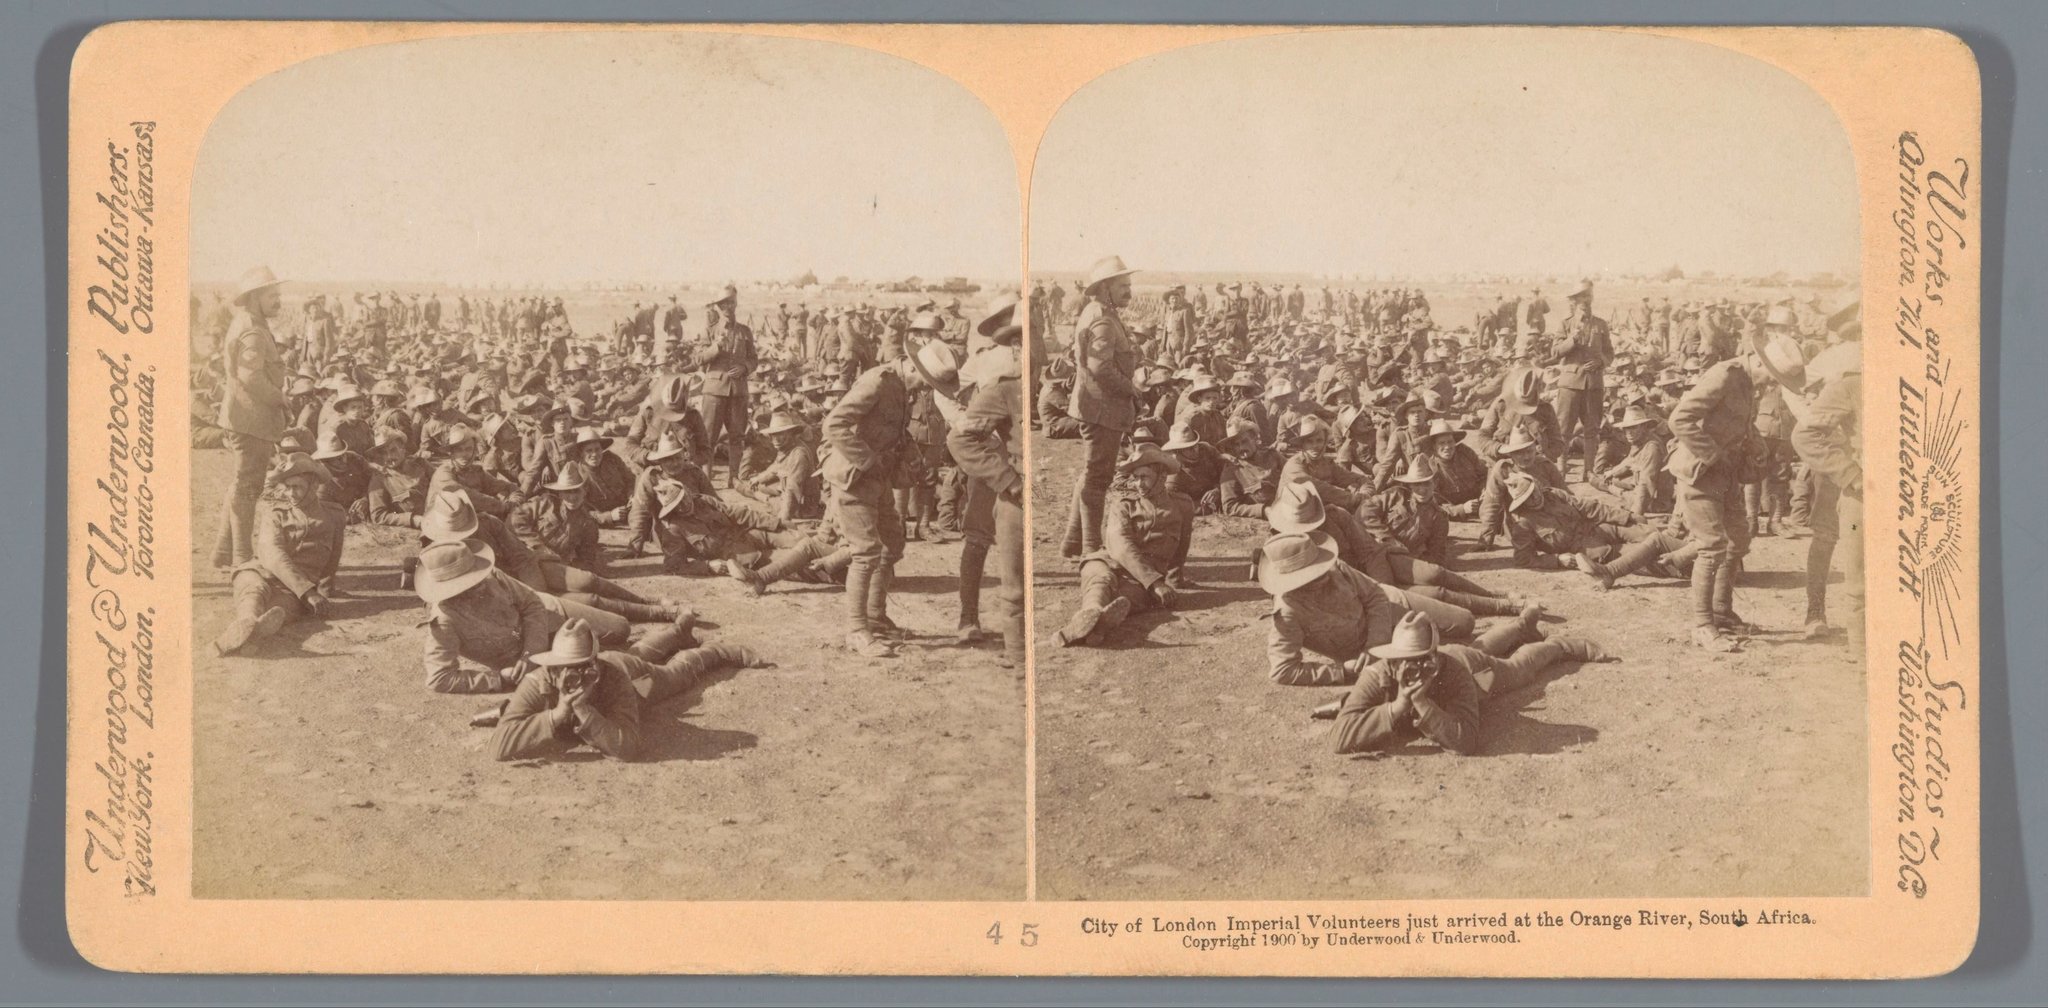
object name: stereograph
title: Voorstelling van Britse soldaten in een veld nabij de Oranjerivier, Zuid-Afrika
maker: Anonymous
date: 1900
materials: cardboard, paper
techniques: albumen print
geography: new york city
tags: the soldier; the soldier's life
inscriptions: inscription, number: ‘45’, copyright notice: ‘Copyright 1900 by Underwood & Underwood.’, inscription: ‘Works and Studios ~/ Arlington, N.J. Littleton, N.H. Washington, D.C.’